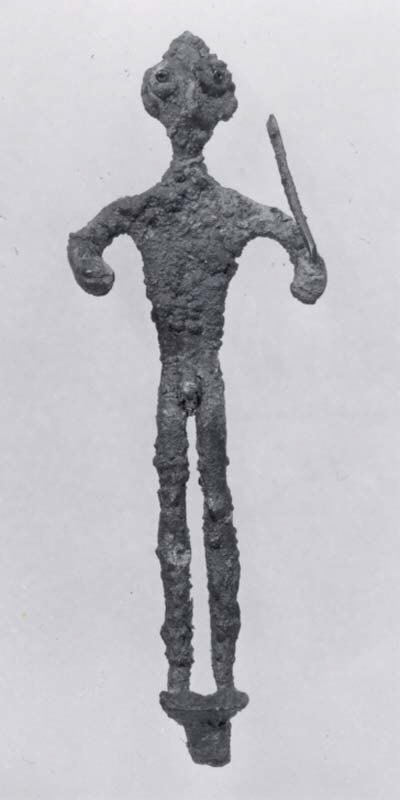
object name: sculpture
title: Smiting god figure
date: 2000-1668 BCE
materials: bronze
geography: northern syria